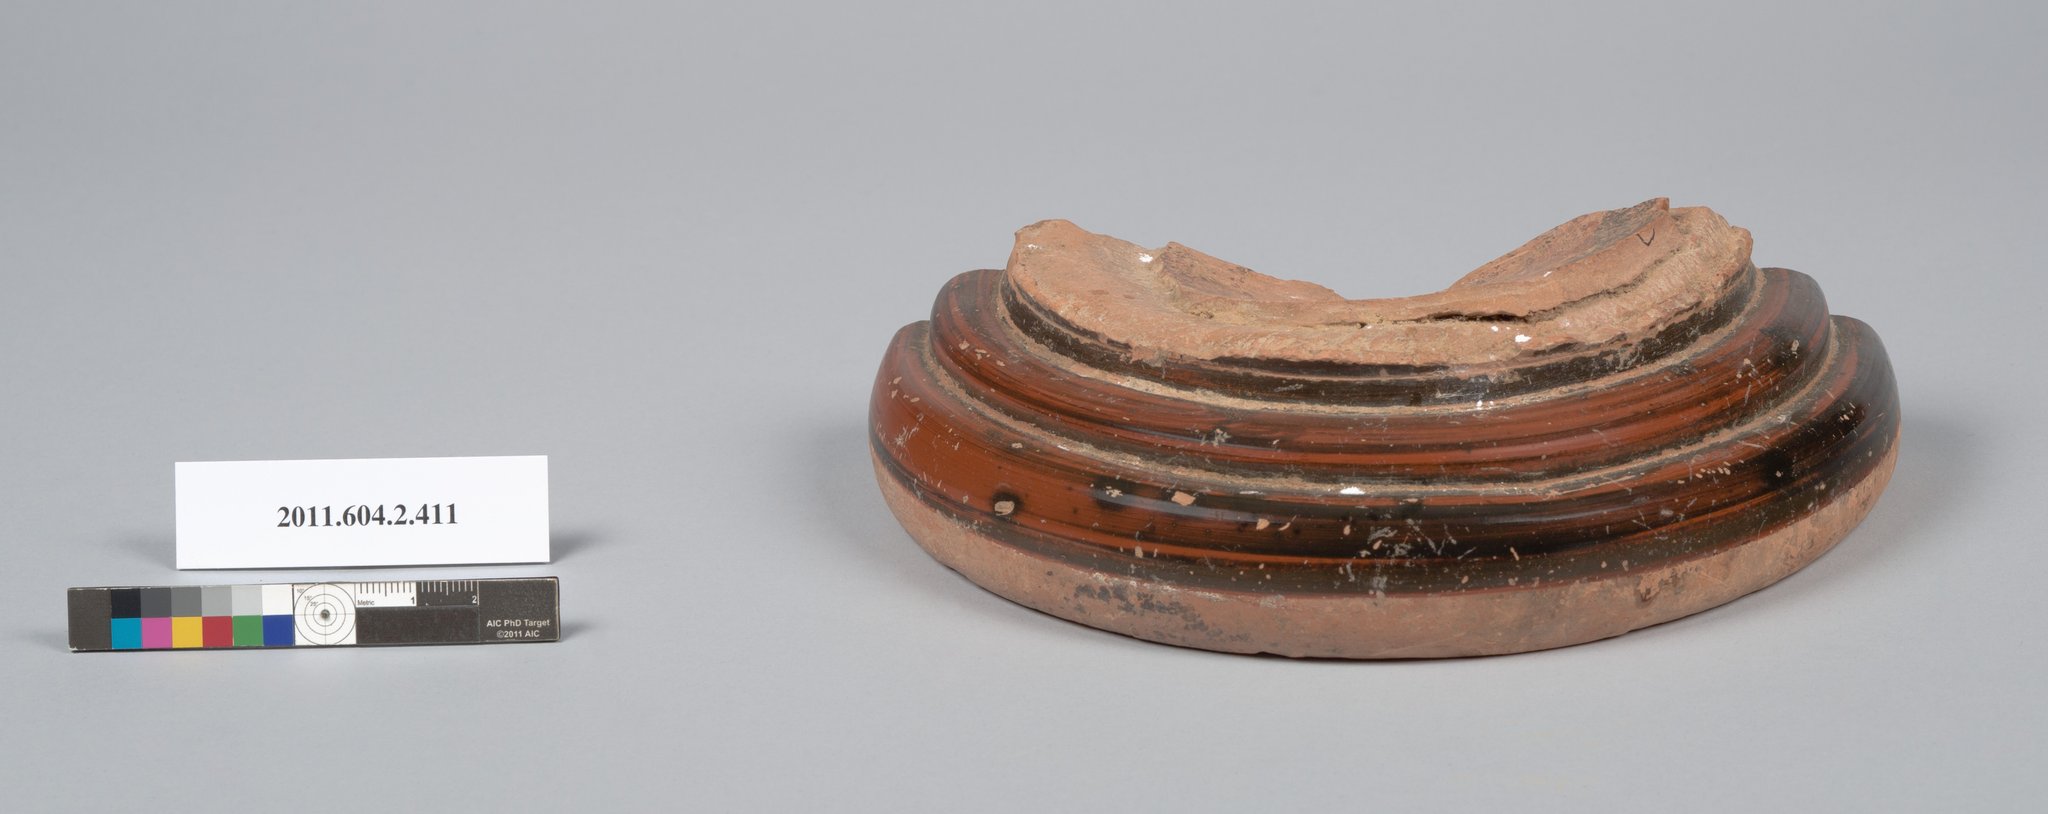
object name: column krater fragment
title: Terracotta fragment of a column-krater (bowl for mixing wine and water)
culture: greek, attic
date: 475-451 BCE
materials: terracotta